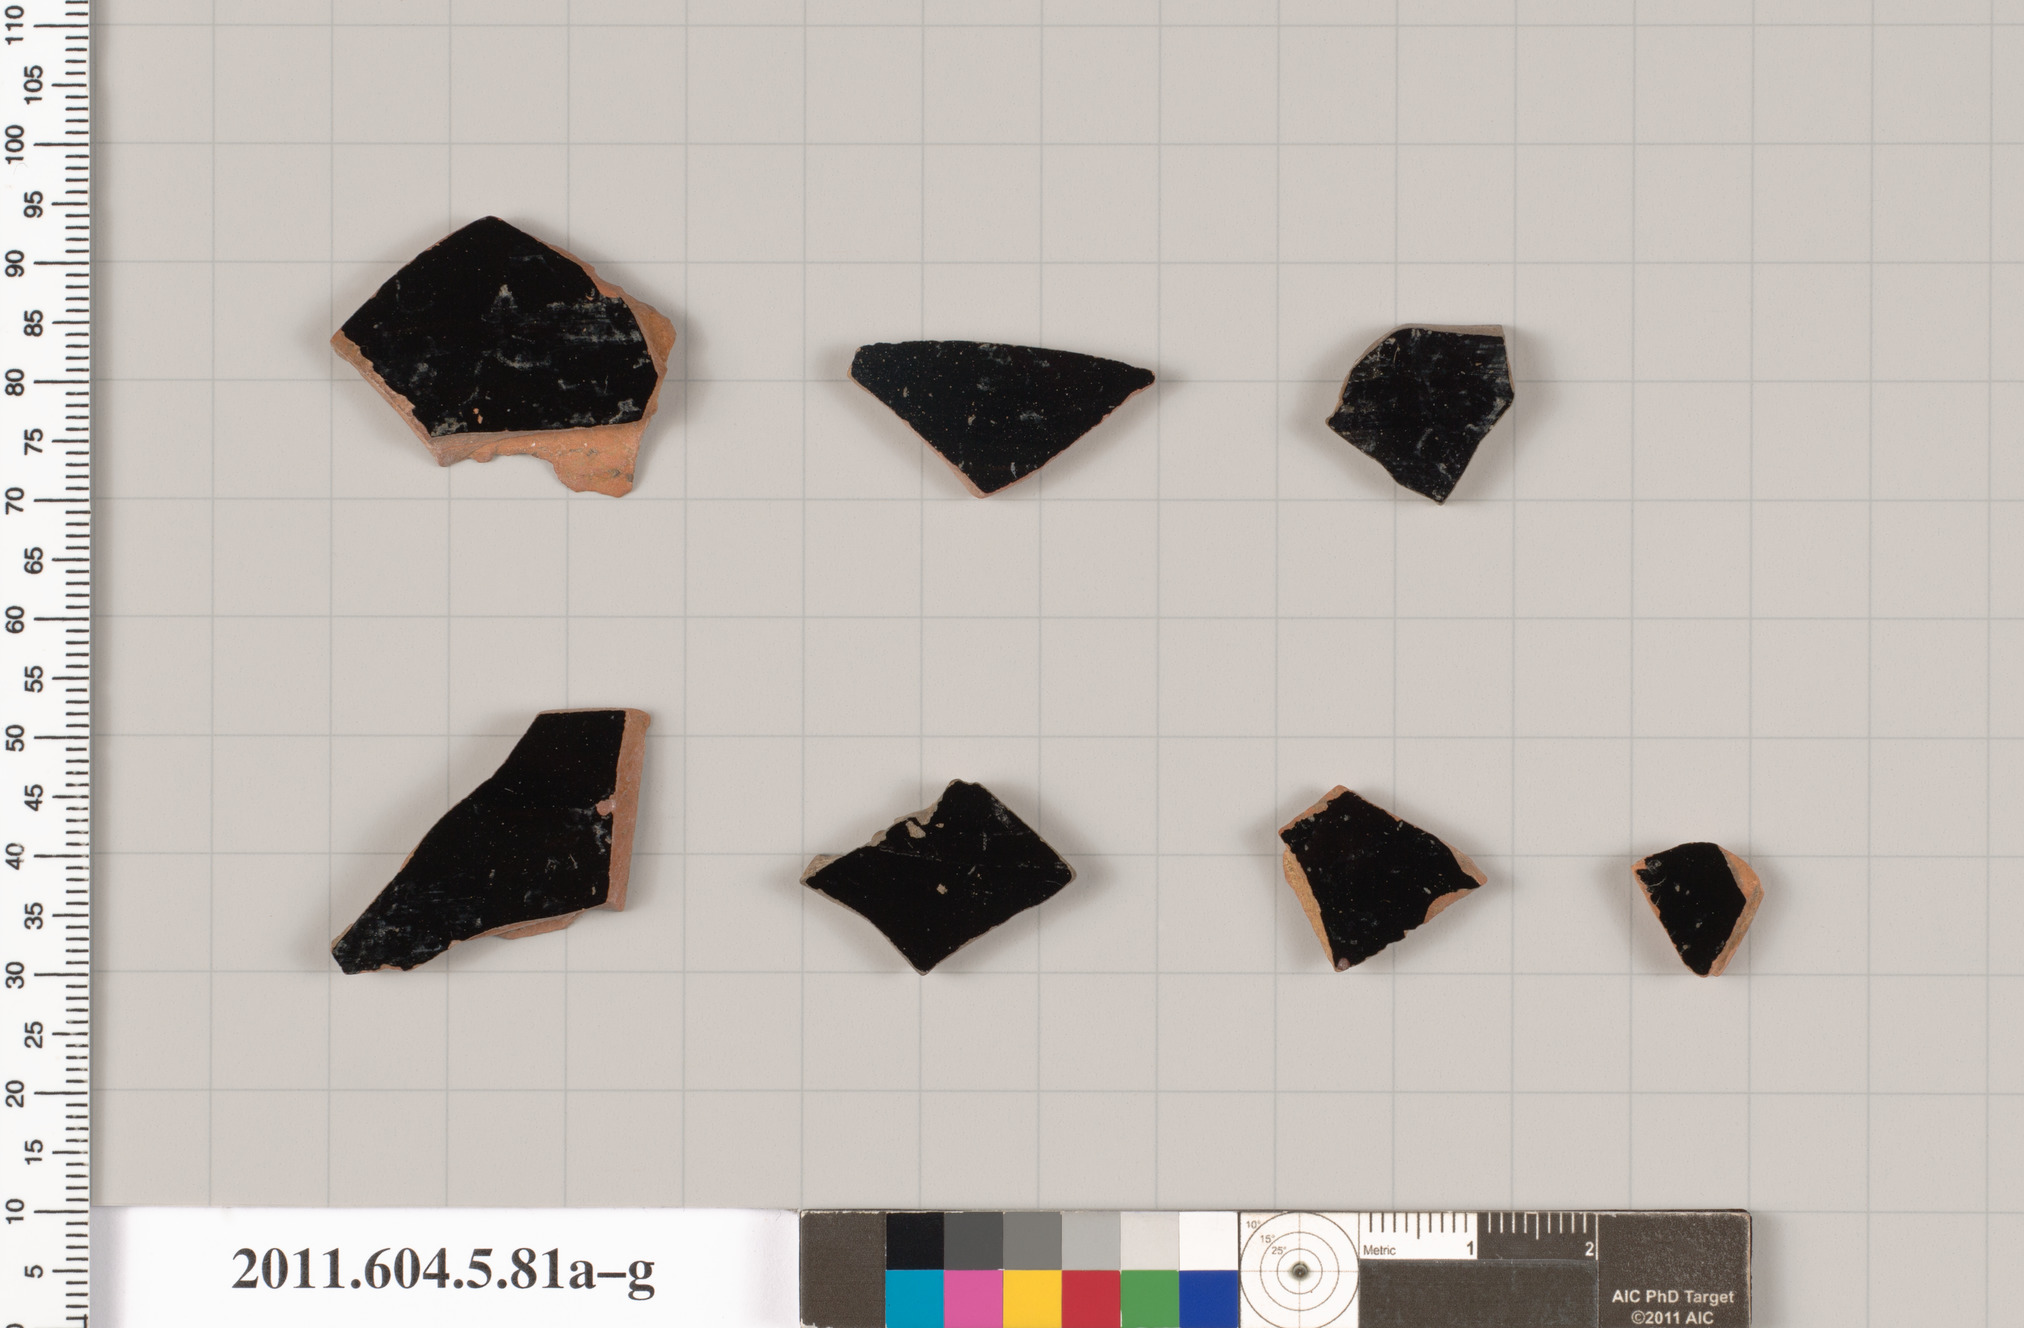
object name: kylix fragment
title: Terracotta fragments of kylikes (drinking cups)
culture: greek, attic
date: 520-480 BCE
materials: terracotta